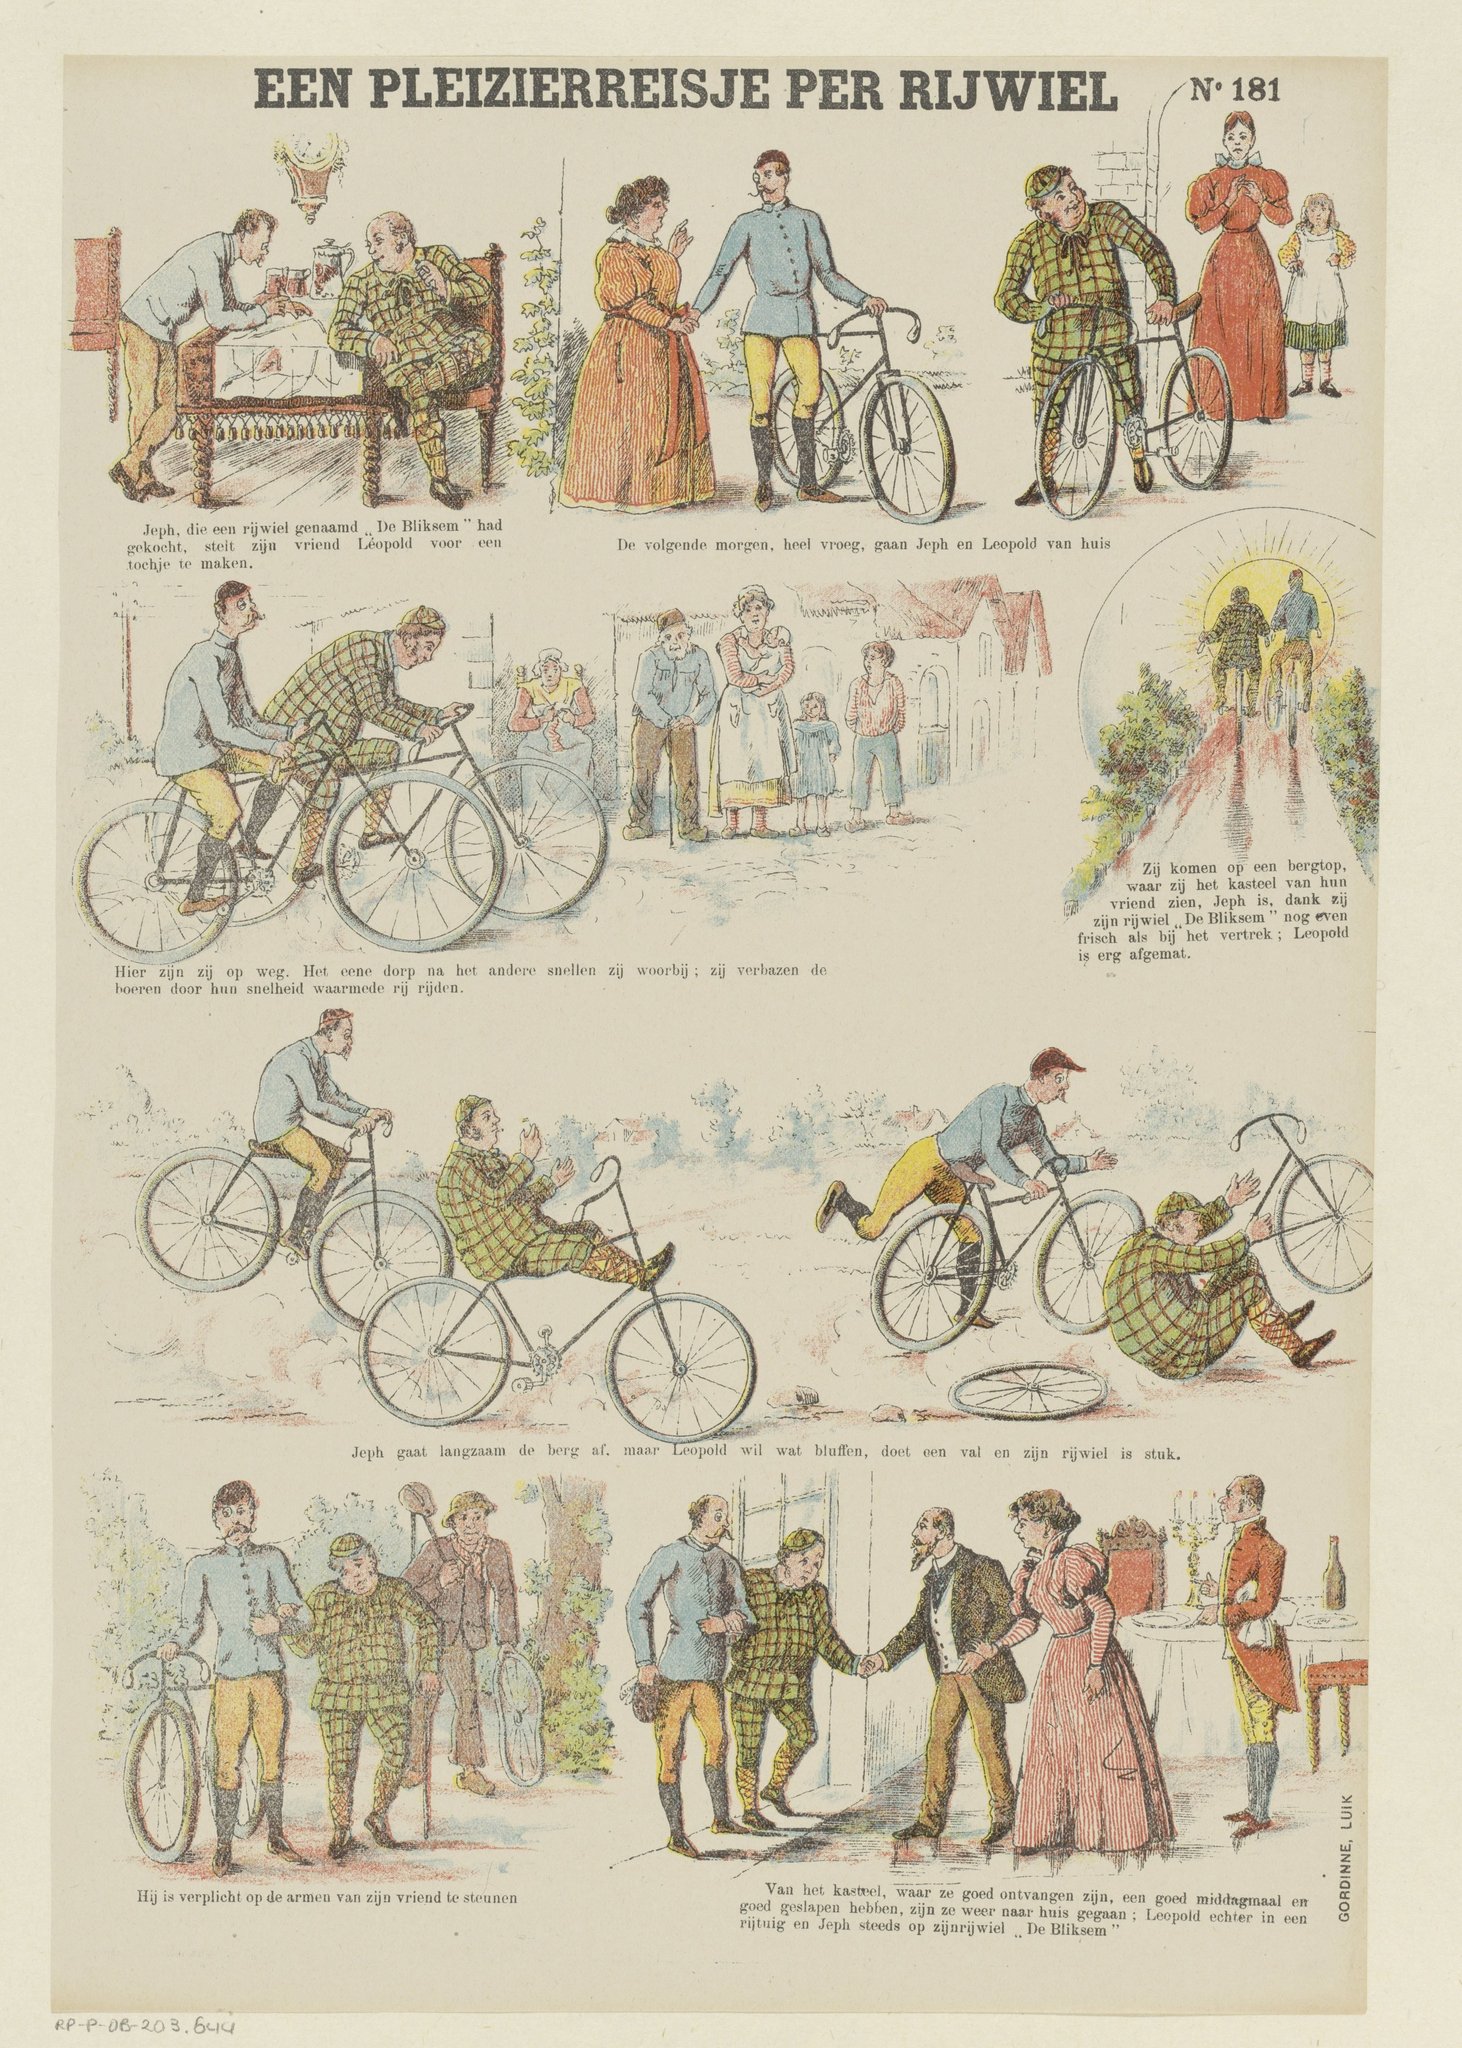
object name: print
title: Een plezierreisje per rijwiel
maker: Anonymous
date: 1894-1959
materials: paper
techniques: lithograph, letterpress printing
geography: liège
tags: riding, cycling (recreation), bicycle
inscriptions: collector's mark: Lugt 2760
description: Blad met 9 voorstellingen over de twee vrienden Jeph en Leopold die samen een stuk gaan fietsen. Onder elke afbeelding een onderschrift. Genummerd rechtsboven: No 181.